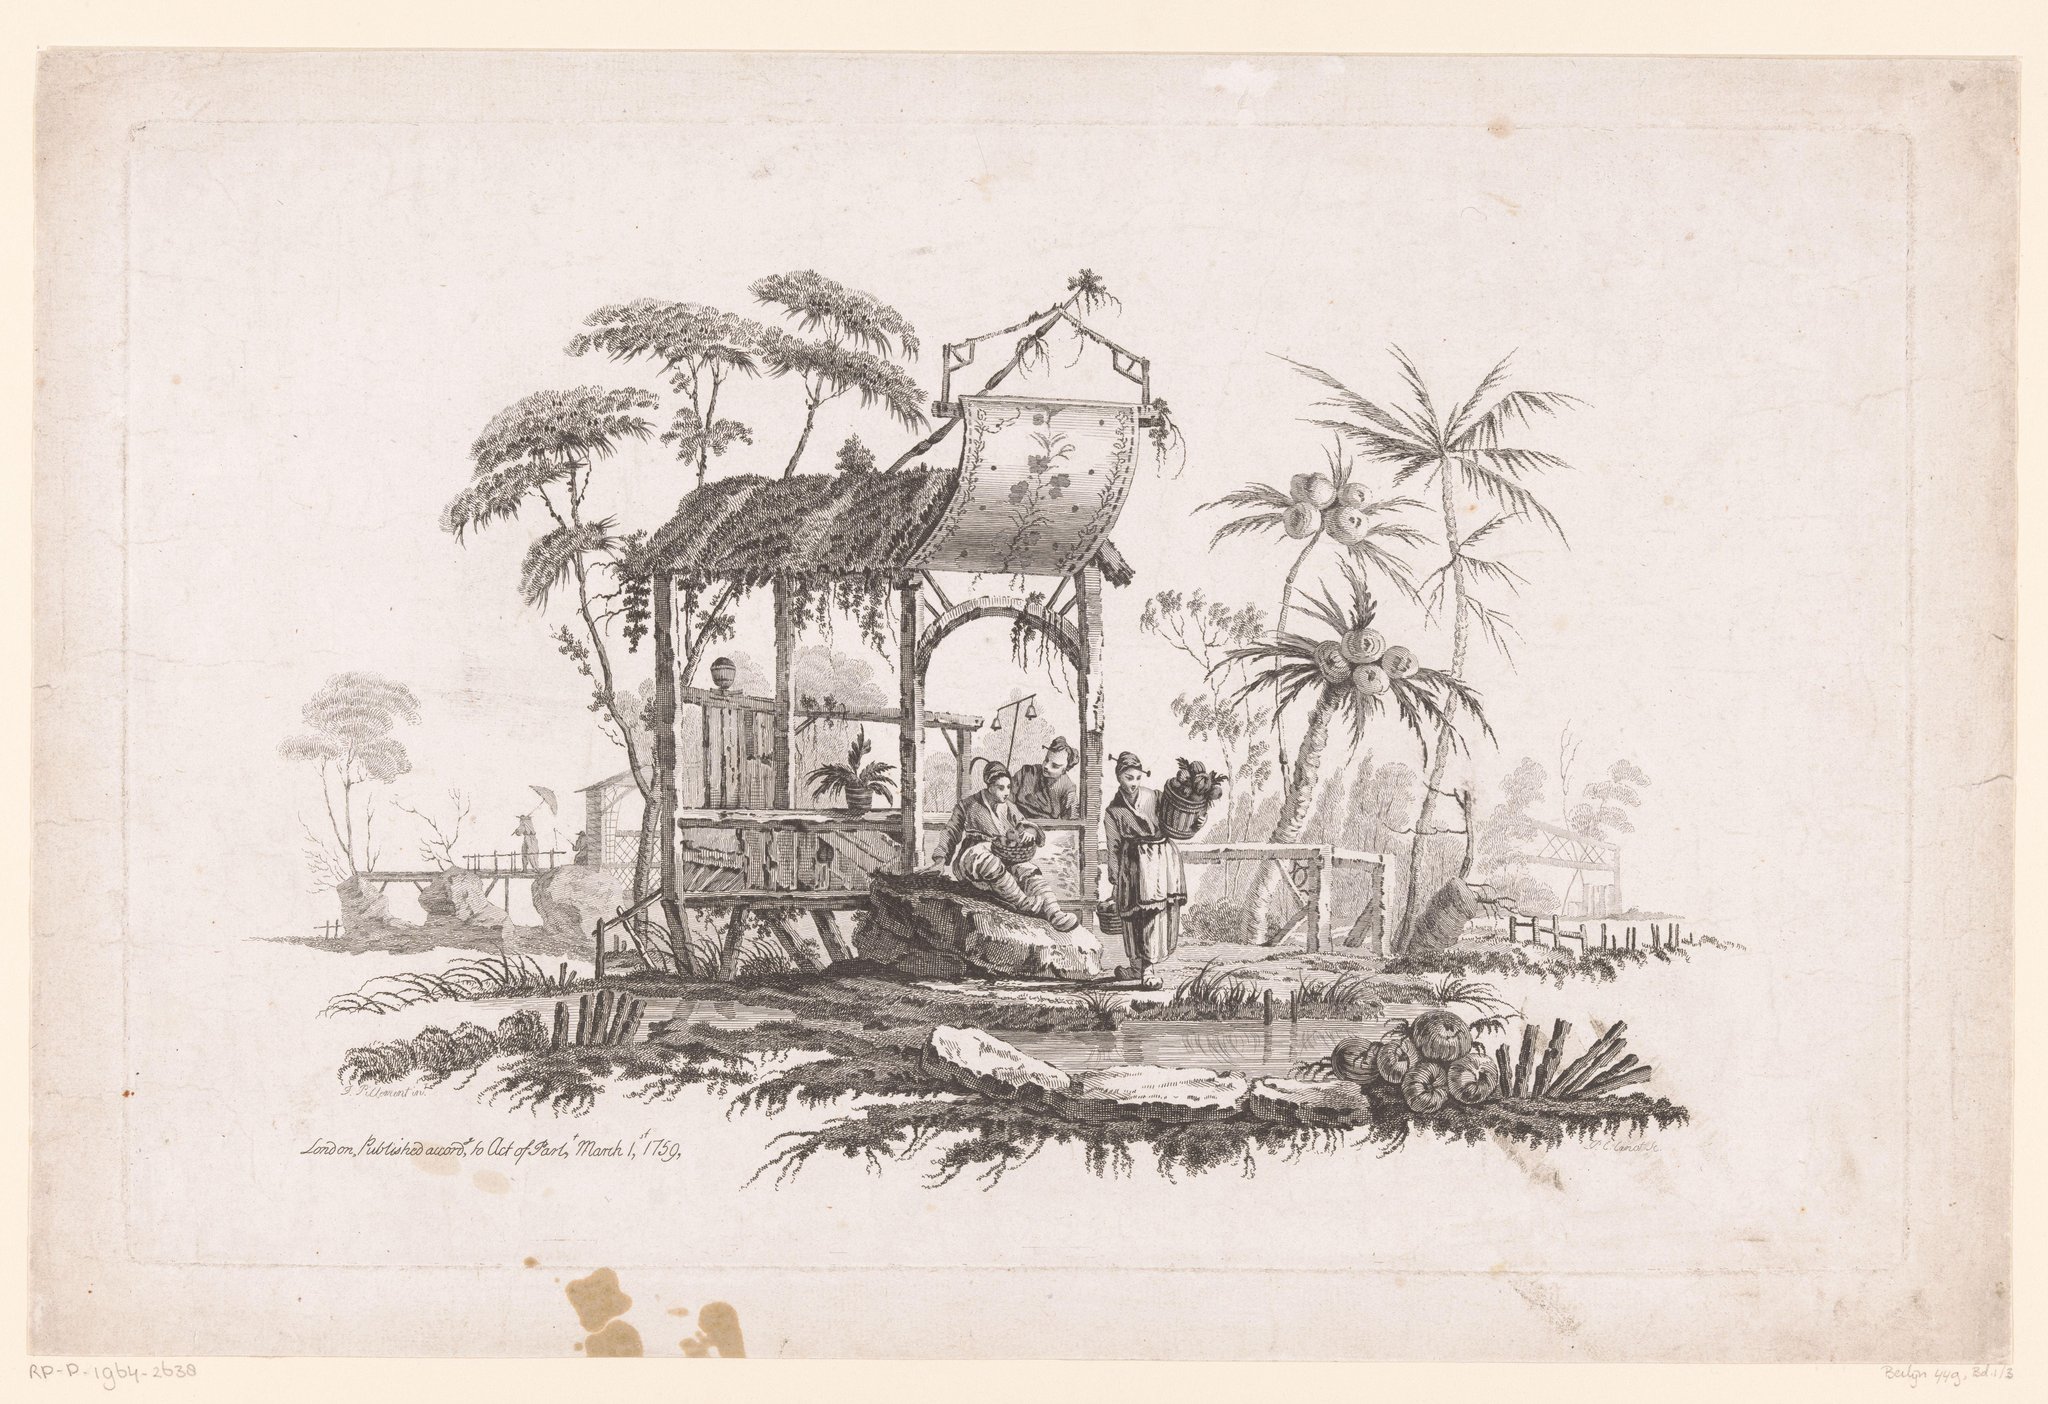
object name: ornament print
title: Figuren met manden op oever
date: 1759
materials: paper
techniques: etching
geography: london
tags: standing figure, container made of plant material other than wood: basket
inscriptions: collector's mark: Lugt 2228, collector's mark: Lugt 2760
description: Bij een houten gebouw op de oever van een rivier bevinden zich een staande en zittende figuur met manden. Een derde figuur met een stok met twee bellen staat achter hen in het gebouw.